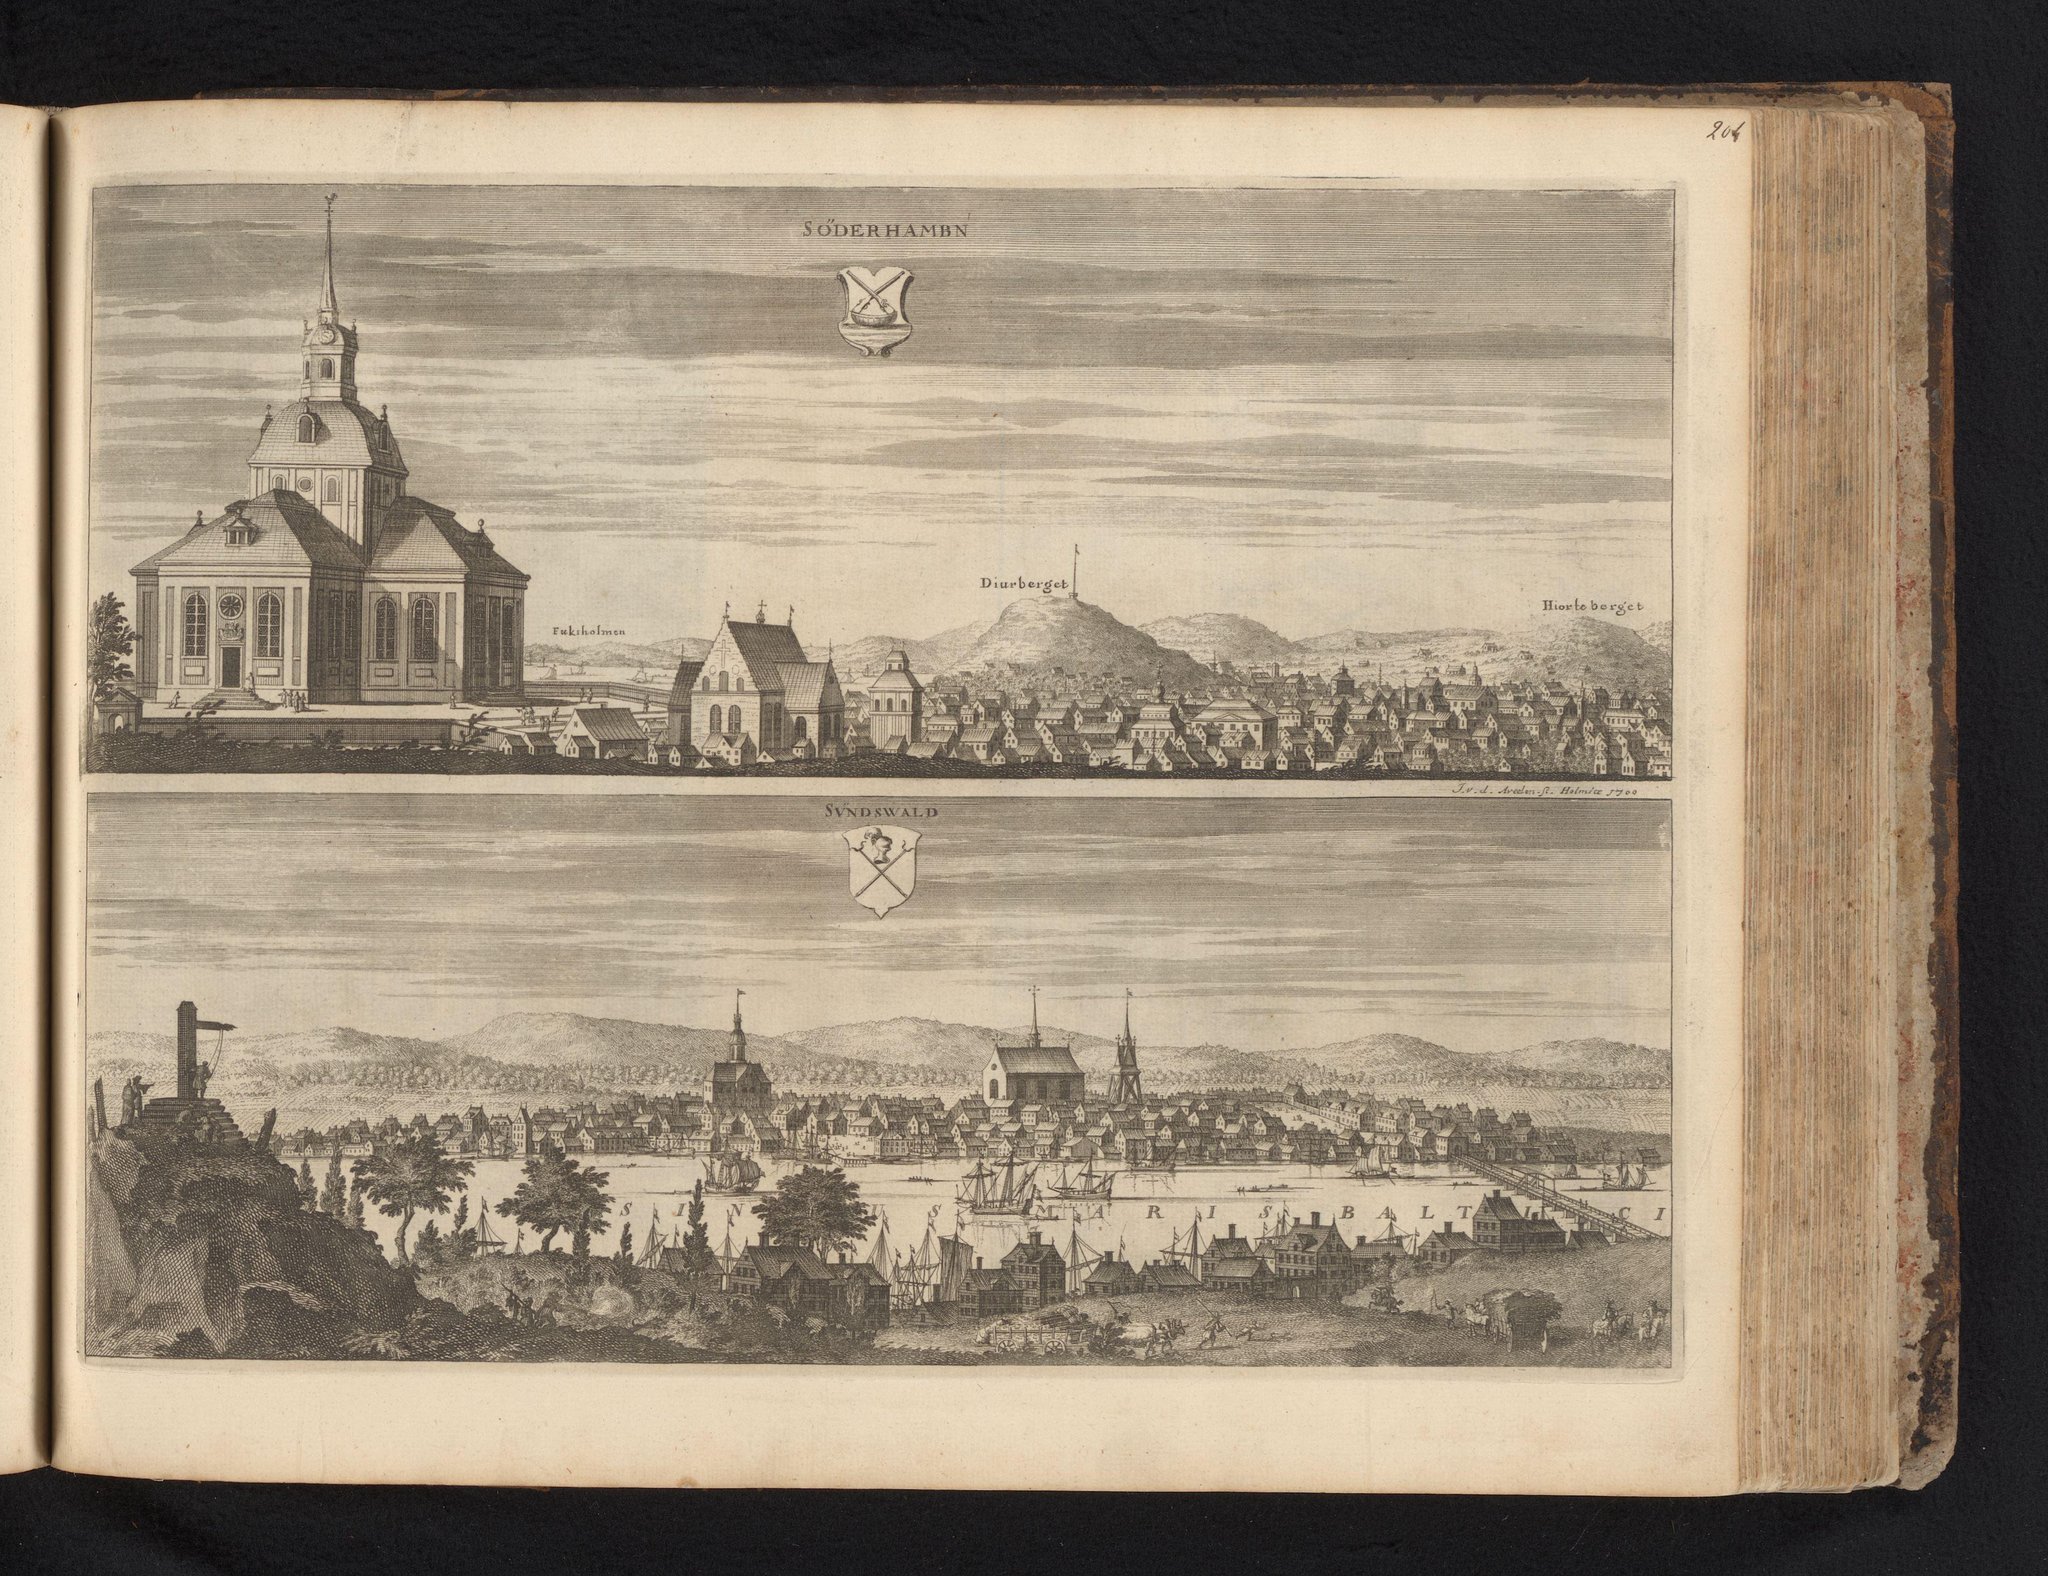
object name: album leaf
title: Gezicht op de stad Söderhamn en Sundsvall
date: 1700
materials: paper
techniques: etching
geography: stockholm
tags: city-view in general; 'veduta'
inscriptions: date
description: Kungliga Biblioteket, 'Suecia': http://www.kb.se/samlingarna/Kartor-bilder/Suecia-antiqua/ (geraadpleegd november 2016).